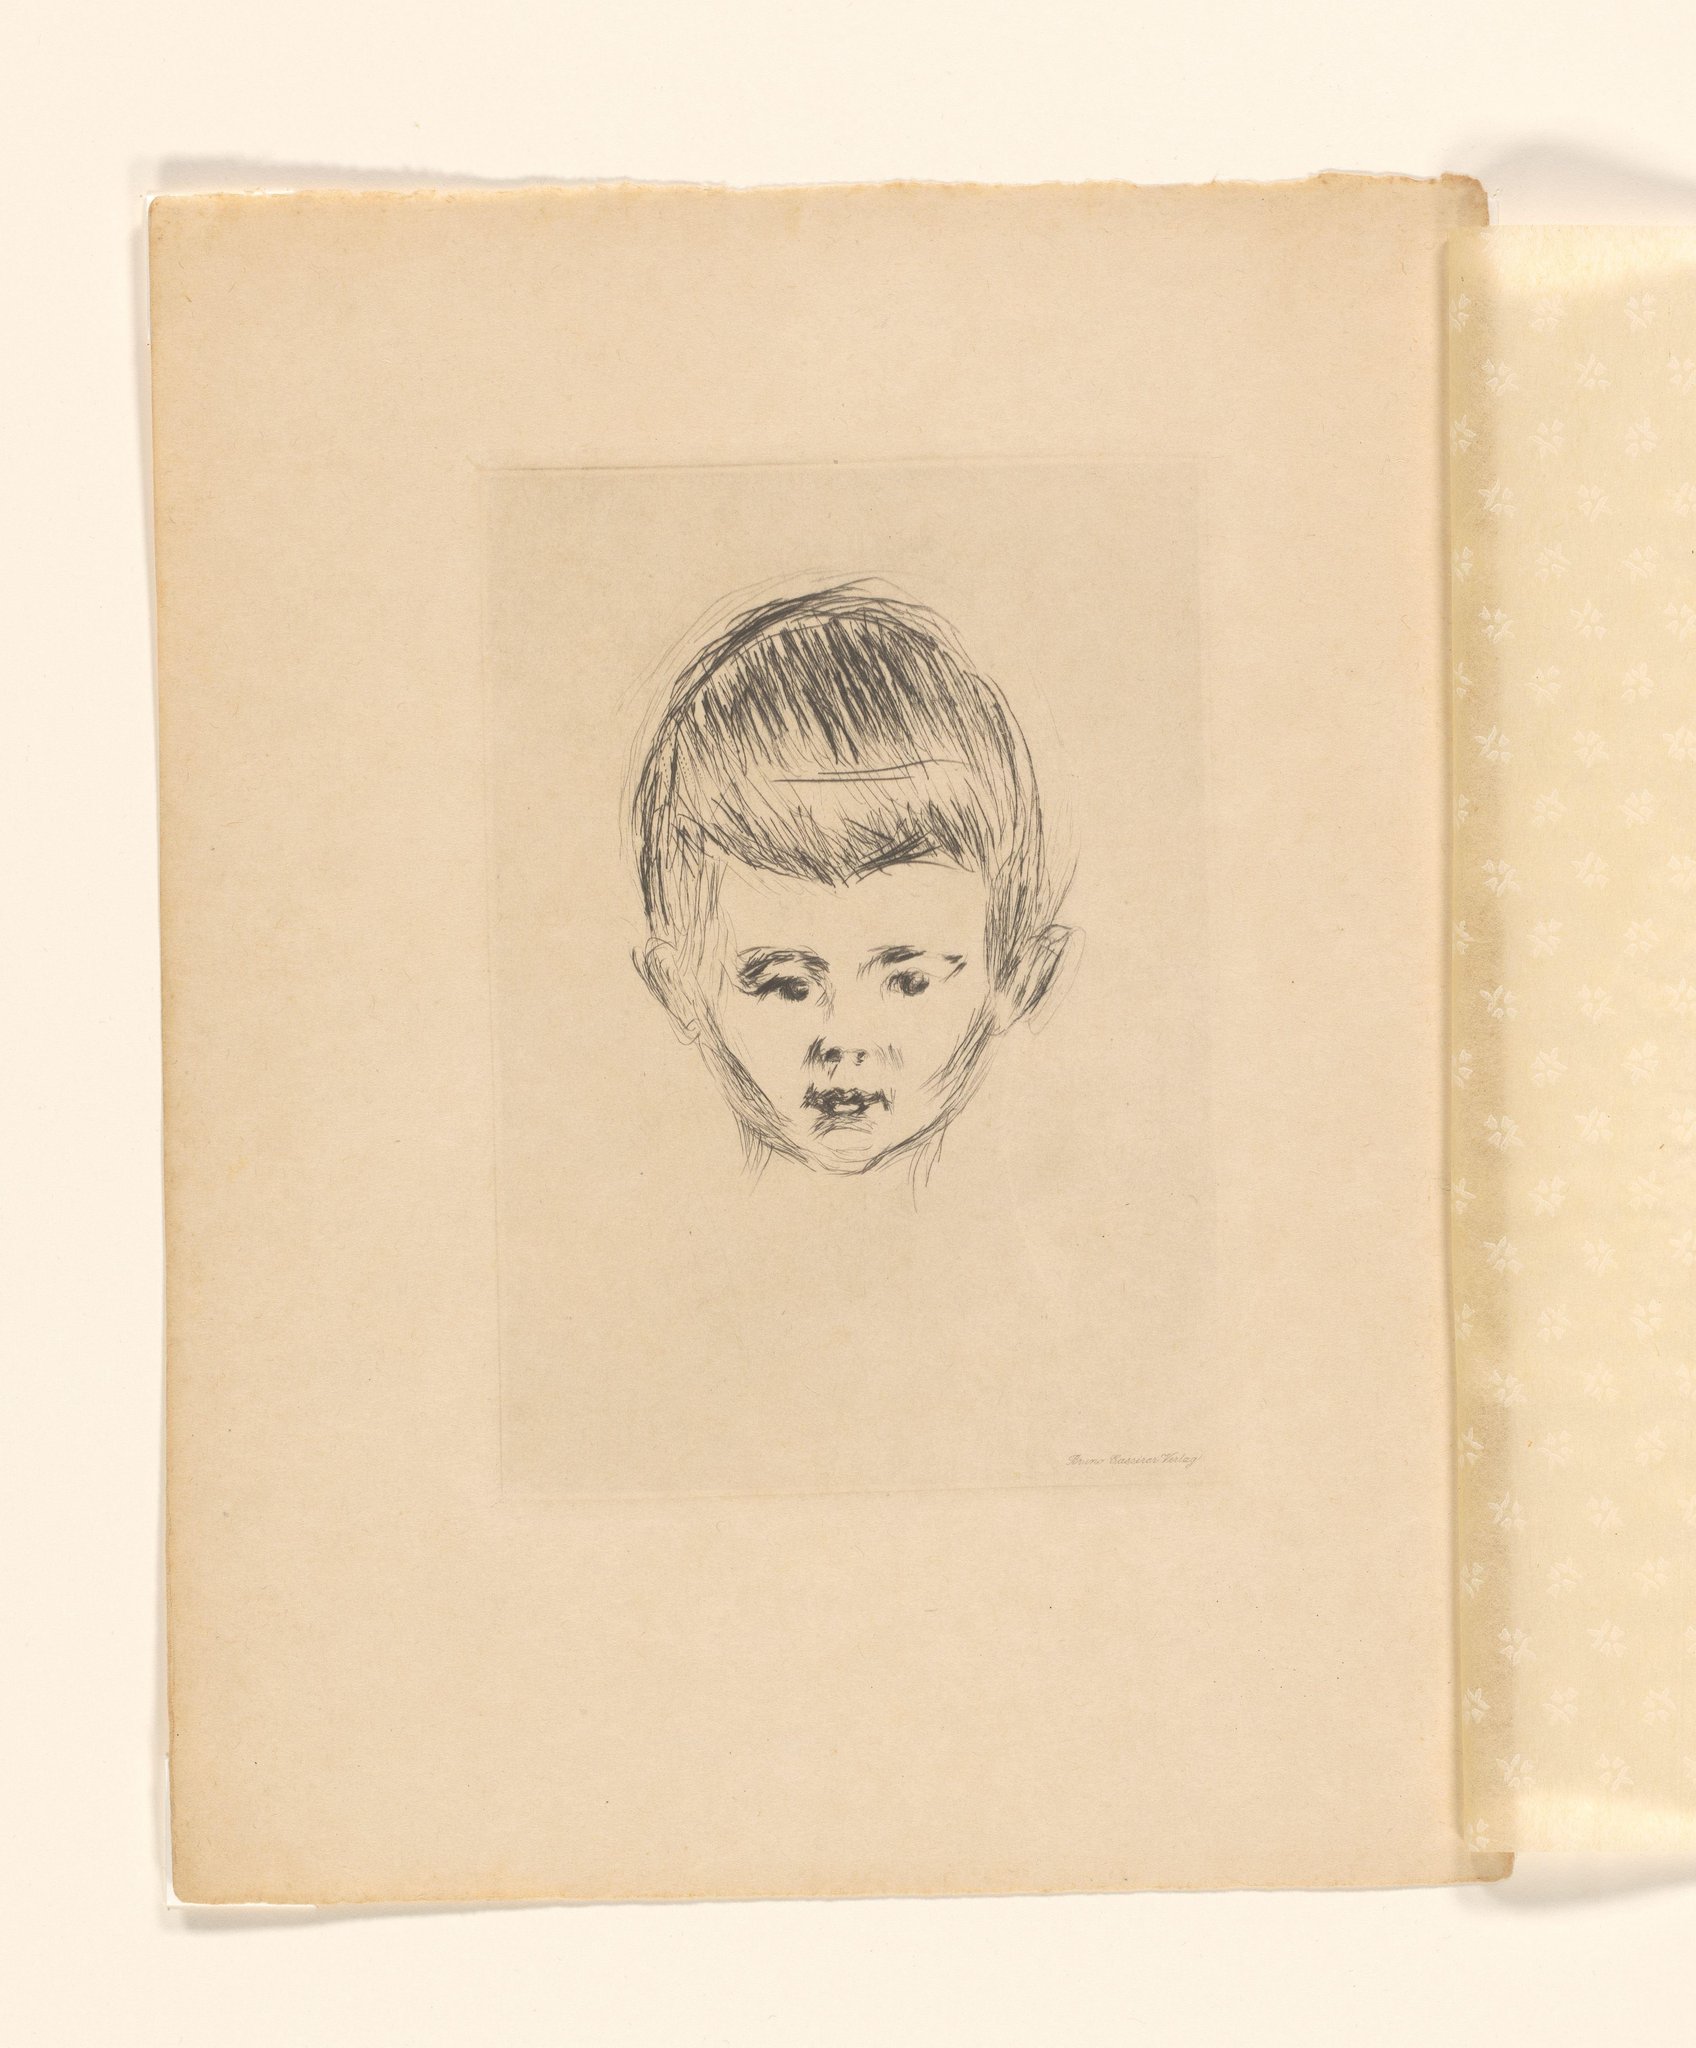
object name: print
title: Portret van Andreas Schwarz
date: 1906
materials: paper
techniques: drypoint, intaglio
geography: berlin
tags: boy (child between toddler and youth), historical persons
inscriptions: collector's mark: Lugt 2228